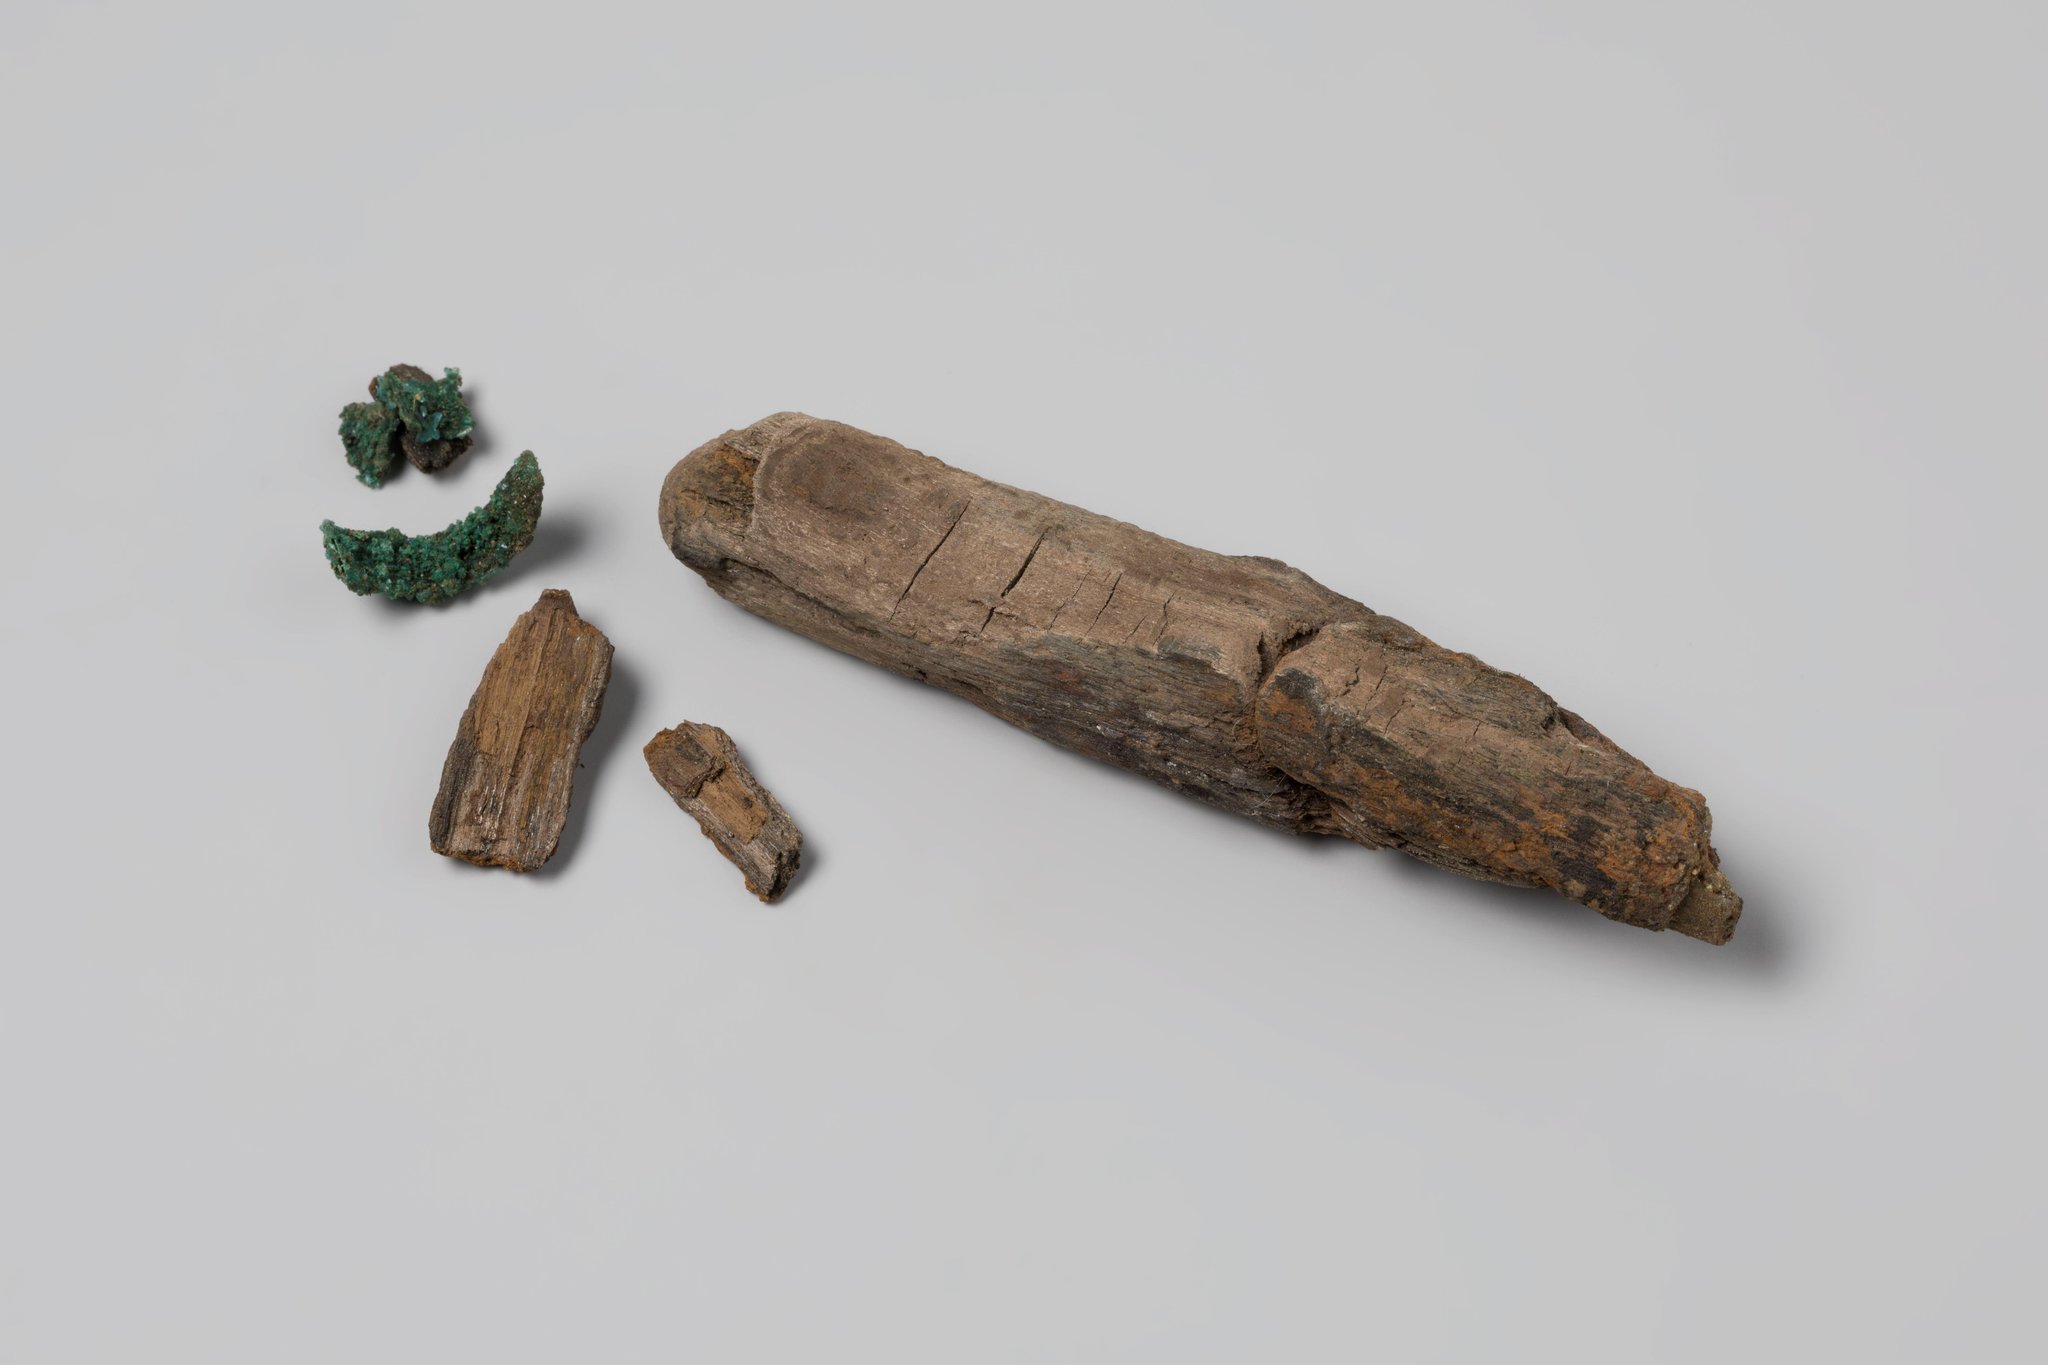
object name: knife handle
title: Messenheft uit het wrak van de Oost-Indiëvaarder Hollandia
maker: Anonymous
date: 1700-1743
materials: copper, wood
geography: netherlands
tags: verenigde oostindische compagnie, hollandia (schip), annet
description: Knife, handle deformed: unclassifiable; fragm, sim. NG 1980-27H1678, ferrule, id. NG 1980-27H426.